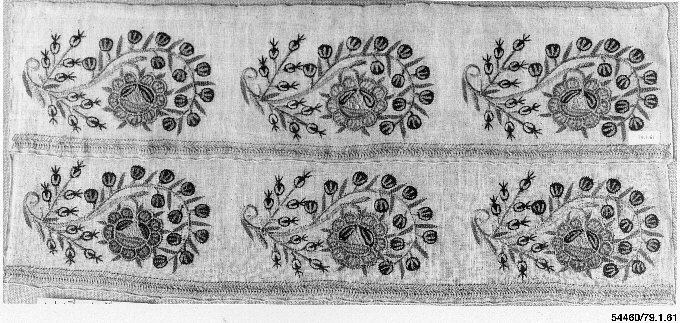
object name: towel end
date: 1801-1833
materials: linen, metal thread, silk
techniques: embroidery, weave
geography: turkey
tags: flowers